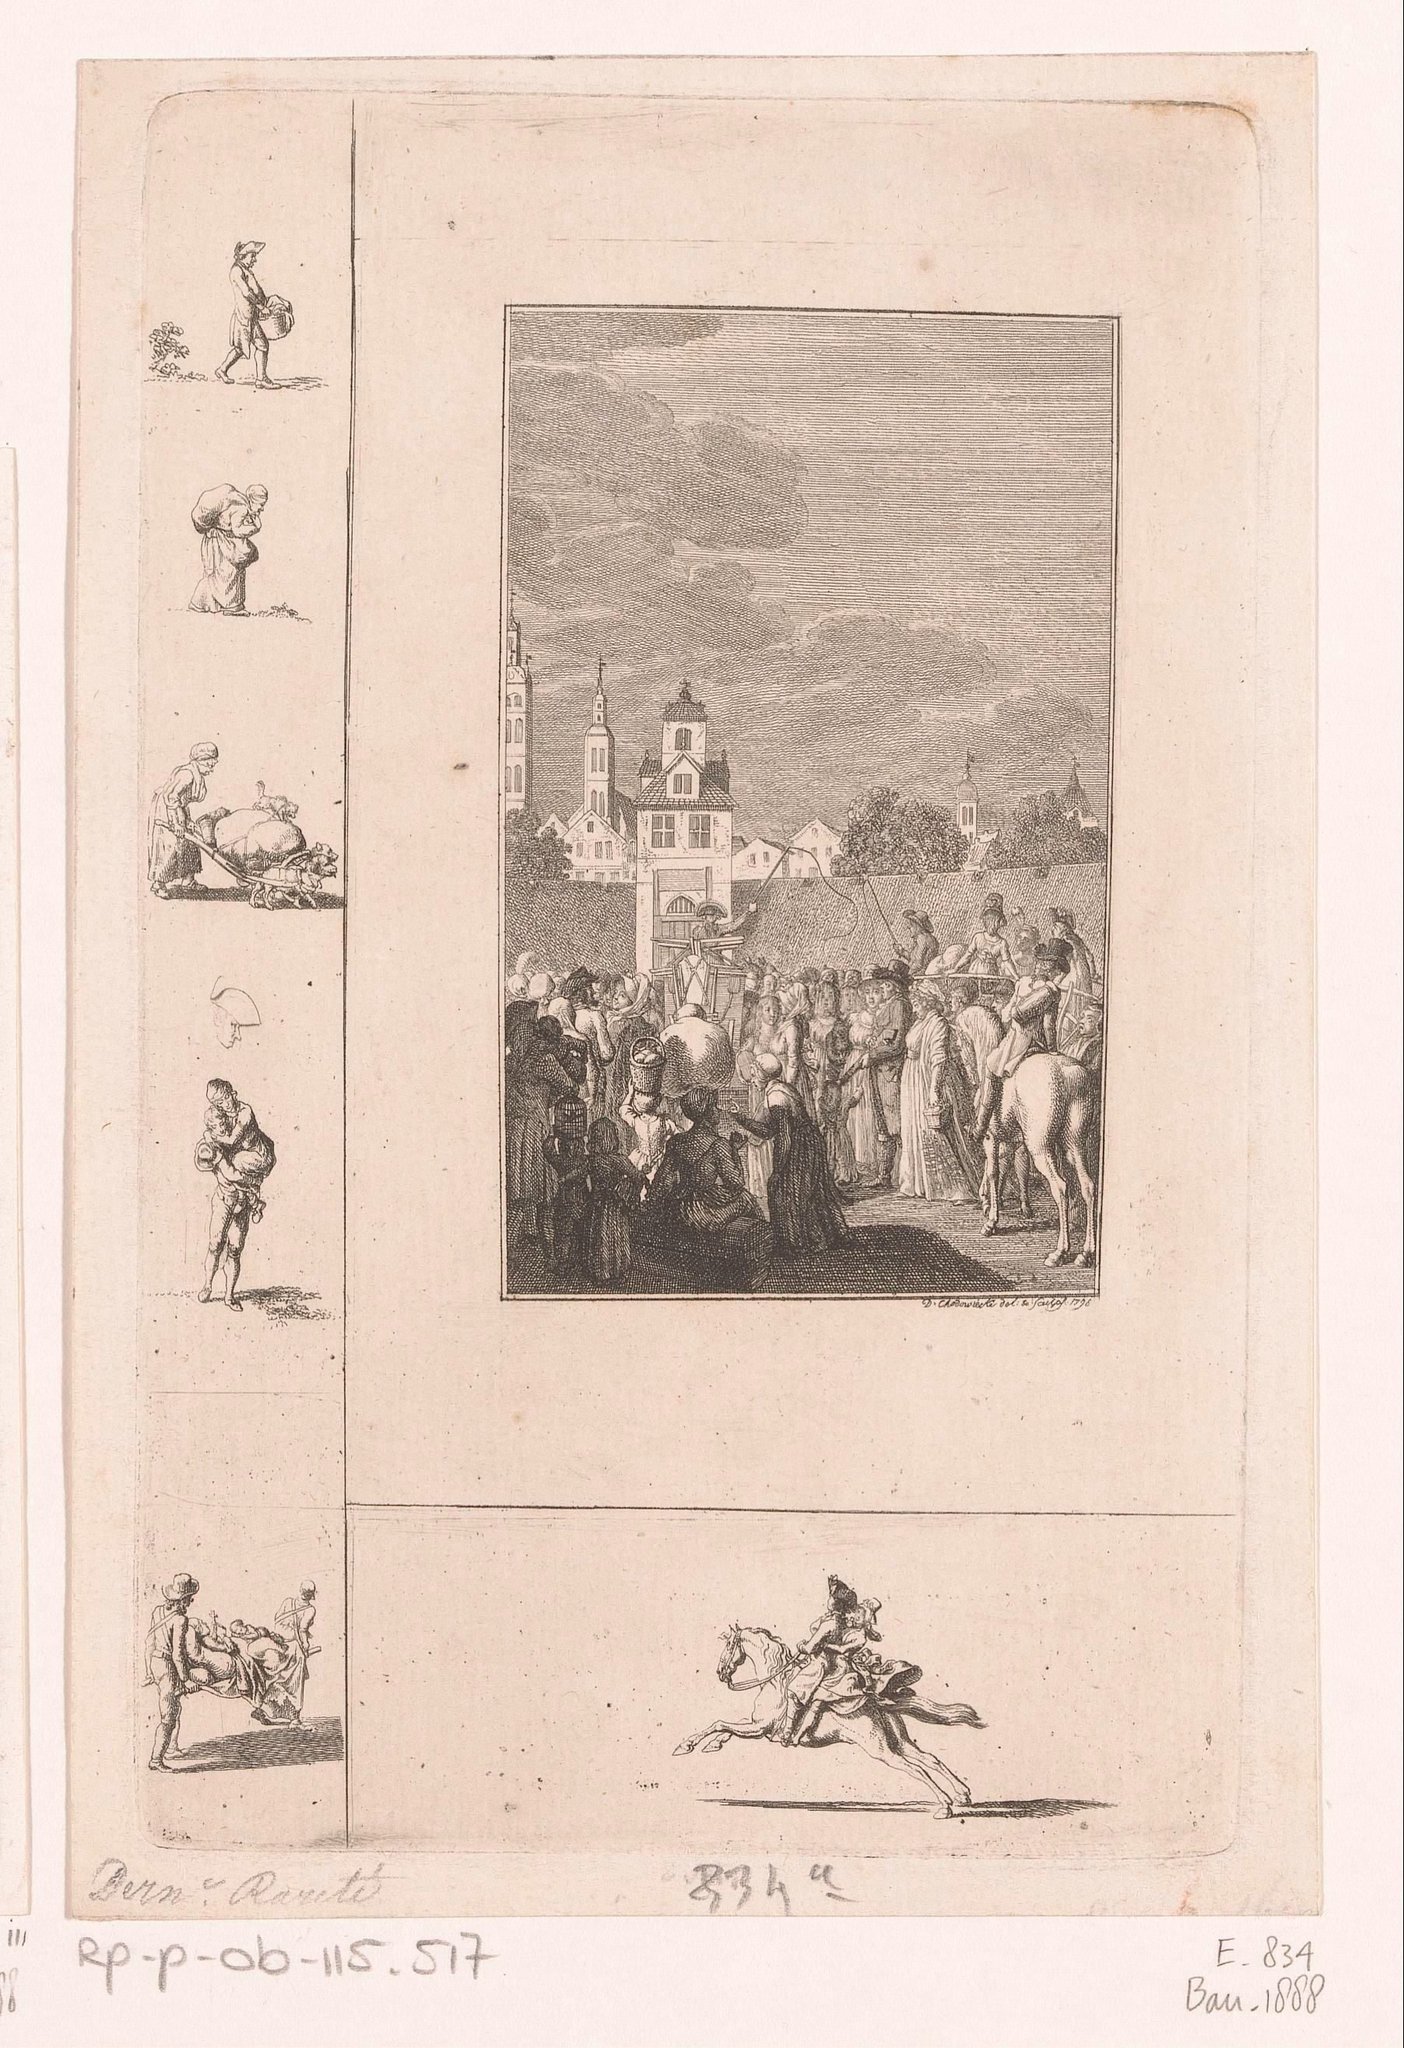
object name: print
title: Vluchtende mensen komen aan bij Hanau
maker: daniel nikolaus chodowiecki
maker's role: draughtsman, print maker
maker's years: 1726-1801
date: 1796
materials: paper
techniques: etching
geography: berlin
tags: riding a horse, ass, or mule; rider, horseman, history, city-gate, political refugee, 'émigré'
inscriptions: collector's mark: Lugt 2228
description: Latere staat gebruikt voor: Ewald, Johann Ludwig. Phantasien auf einer Reise und bei der Flucht vor den Franken. Berlijn: Johann Friedrich Unger, 1797.